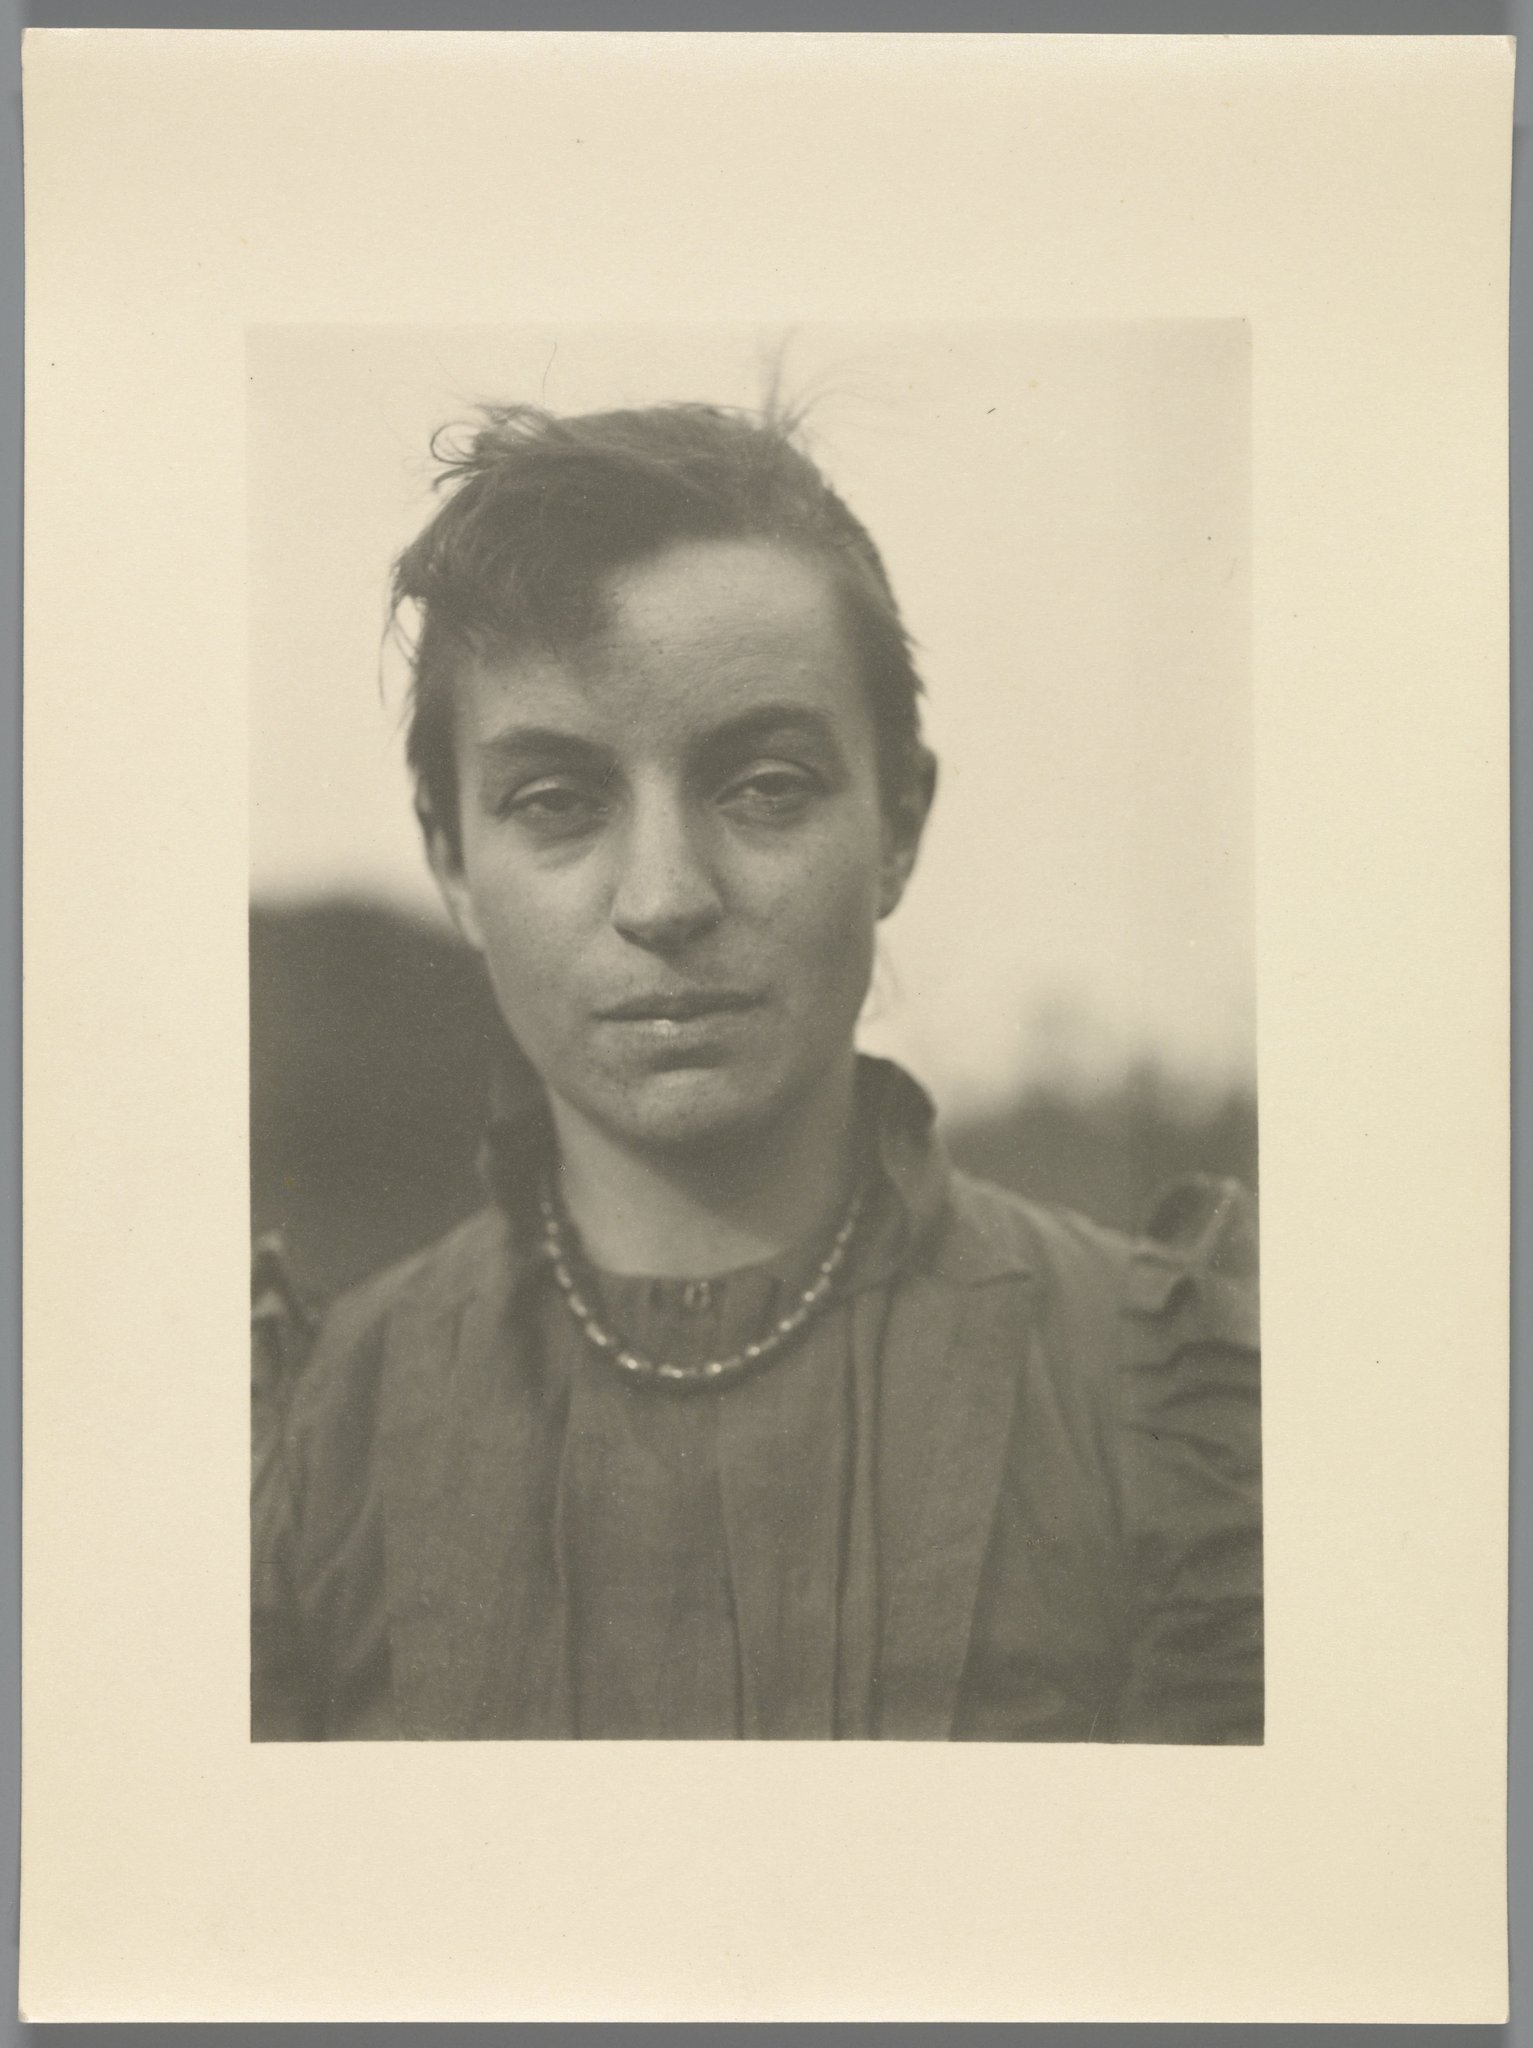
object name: photograph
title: Reproductie naar een foto van Willem Witsen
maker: Anonymous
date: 1860-1915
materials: paper, photographic support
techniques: gelatin silver print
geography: netherlands